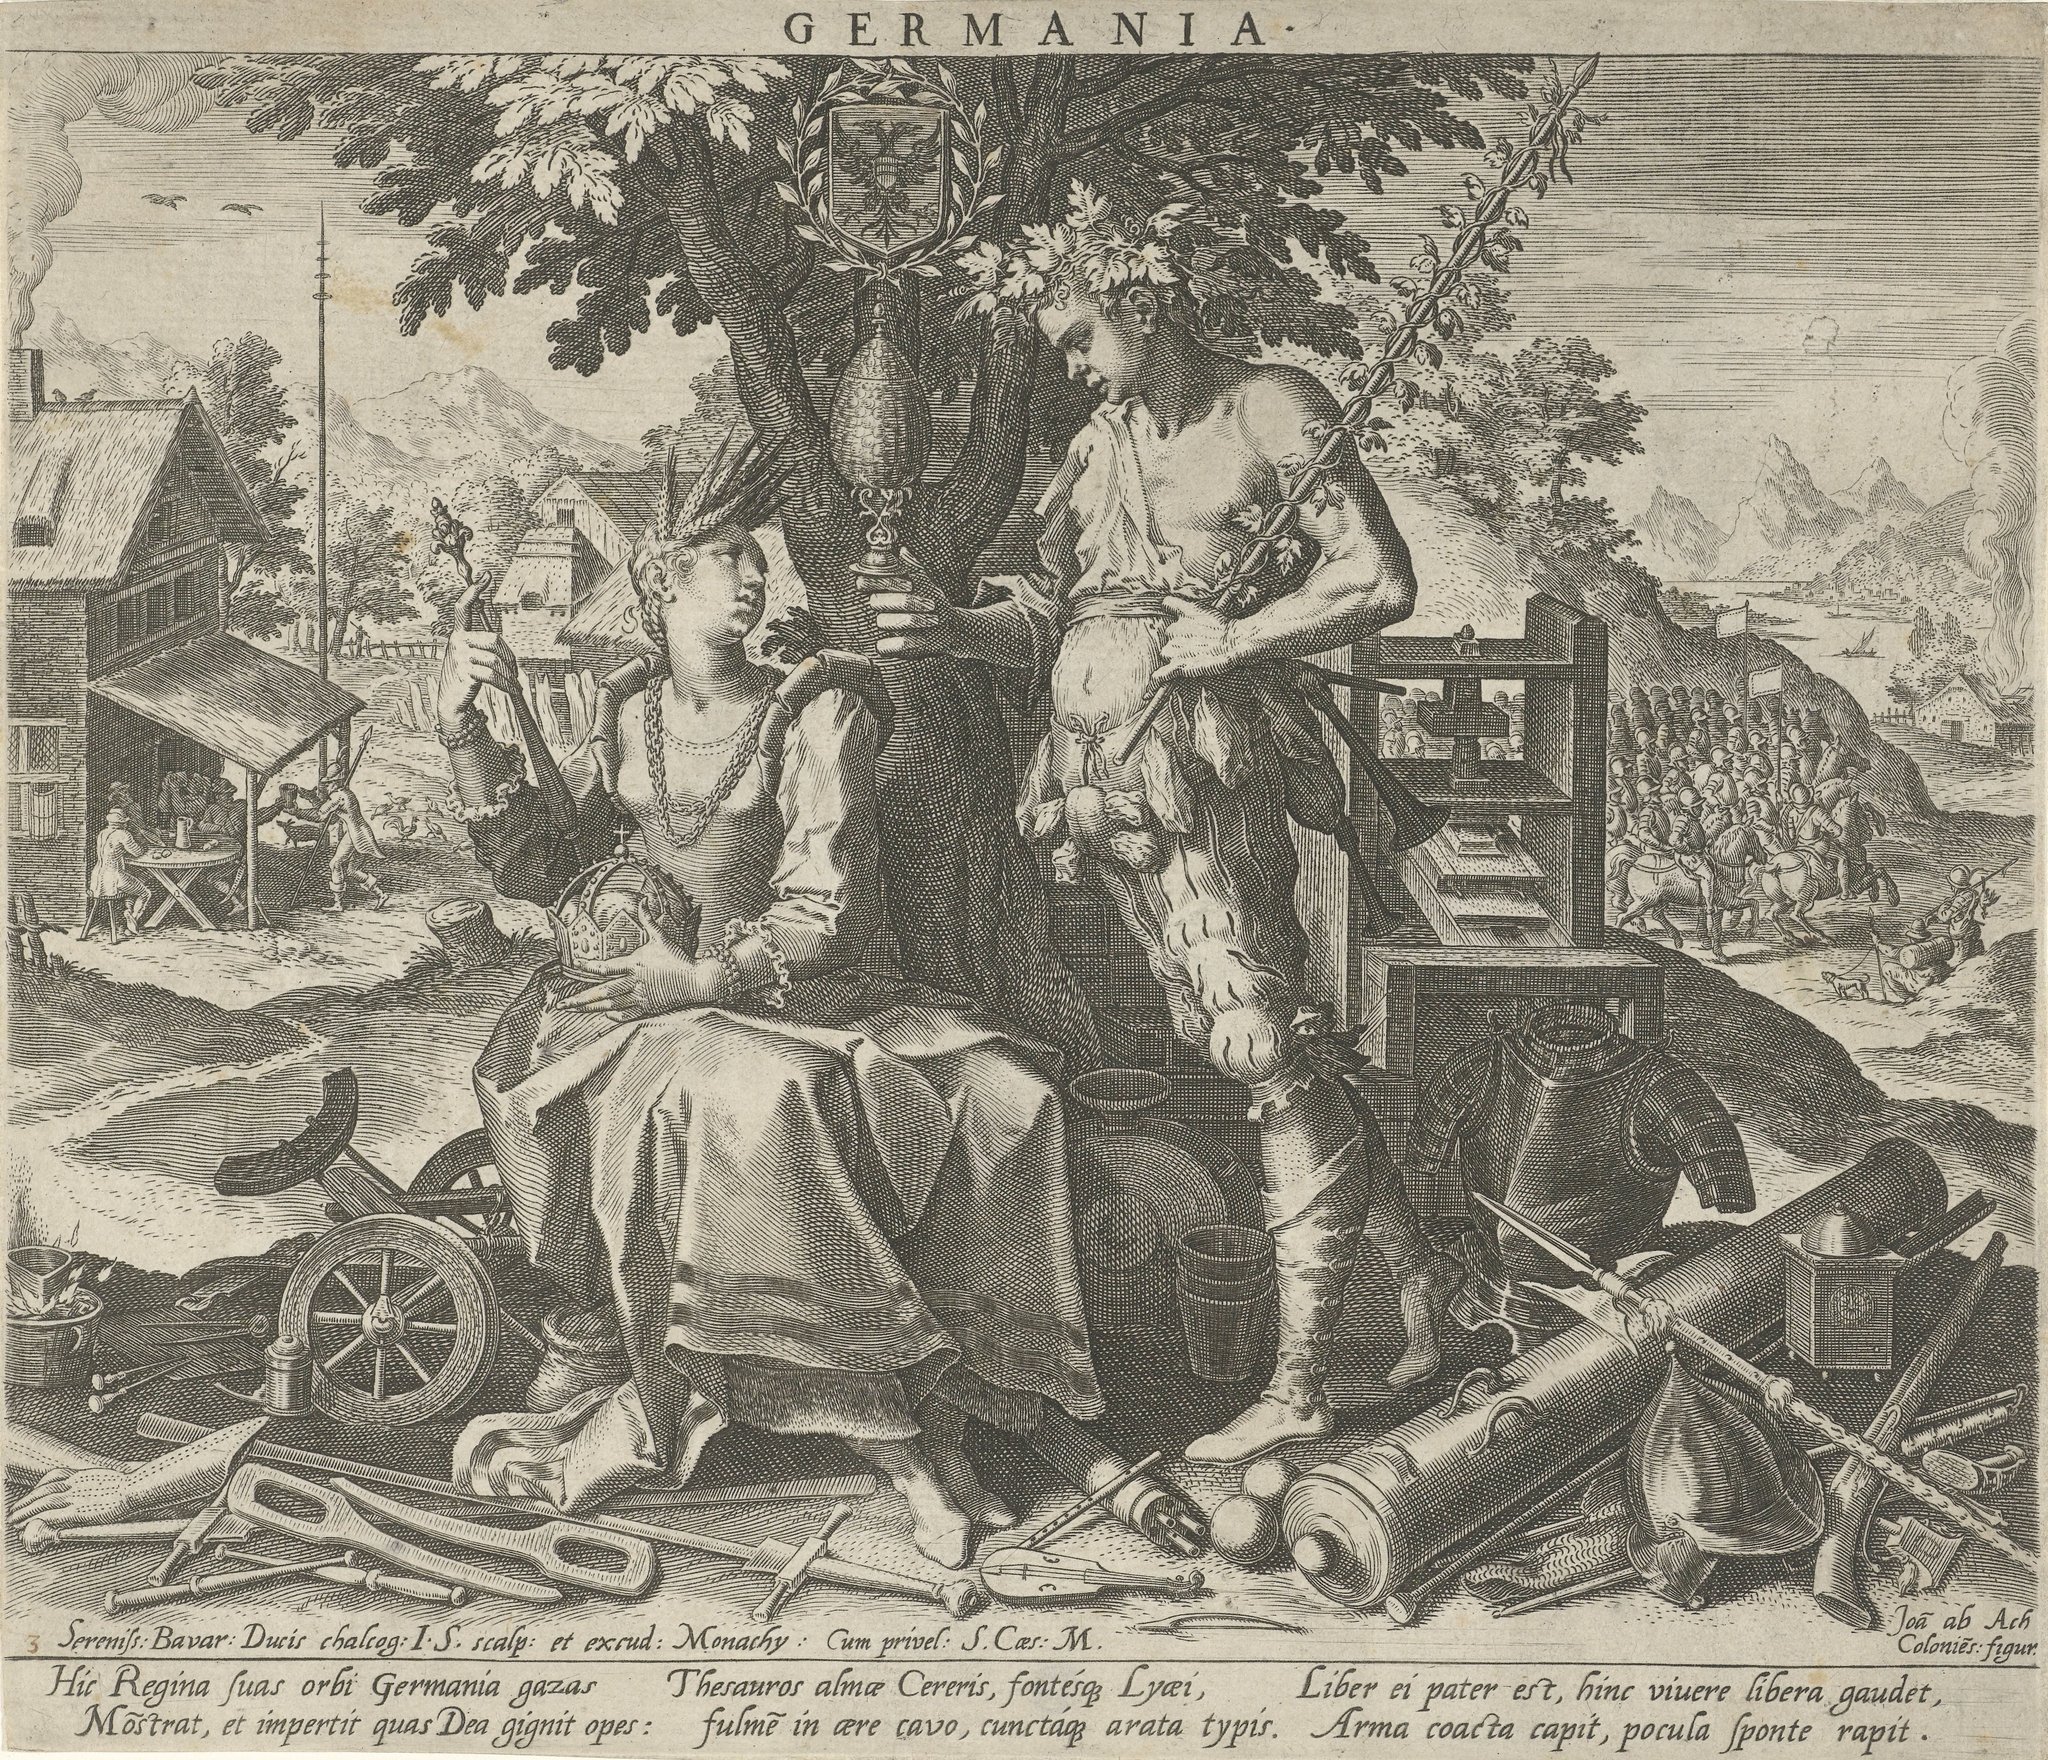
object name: print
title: Allegorische voorstellingen van Europese landen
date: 1588-1595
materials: paper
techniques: engraving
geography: cologne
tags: army 'en route', (story of) ceres (demeter), (story of) bacchus (dionysus), liber, personifications of countries, nations, states, districts, etc., farmers, pavement, terrace in front of inn or restaurant, celebration meal, feast, banquet, germany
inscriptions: collector's mark: Lugt 1855a, collector's mark: Lugt 2228, collector's mark: Lugt 700a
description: Een allegorie op Duitsland. In het midden onder een boom de goden Ceres (landbouw) en Bacchus (wijn). Ceres houdt een scepter in de handen. Op haar schoot de Duitse keizerskroon. Bacchus heeft de rijksappel en een wijnrank vast. Rondom hen op de grond liggen wapentuig en landbouwwerktuigen. Achter hen een drukpers. Op de achtergrond rechts feestende boeren, links een leger. De prent maakt deel uit van een vierdelige serie met allegorische voorstellingen van Europese landen.